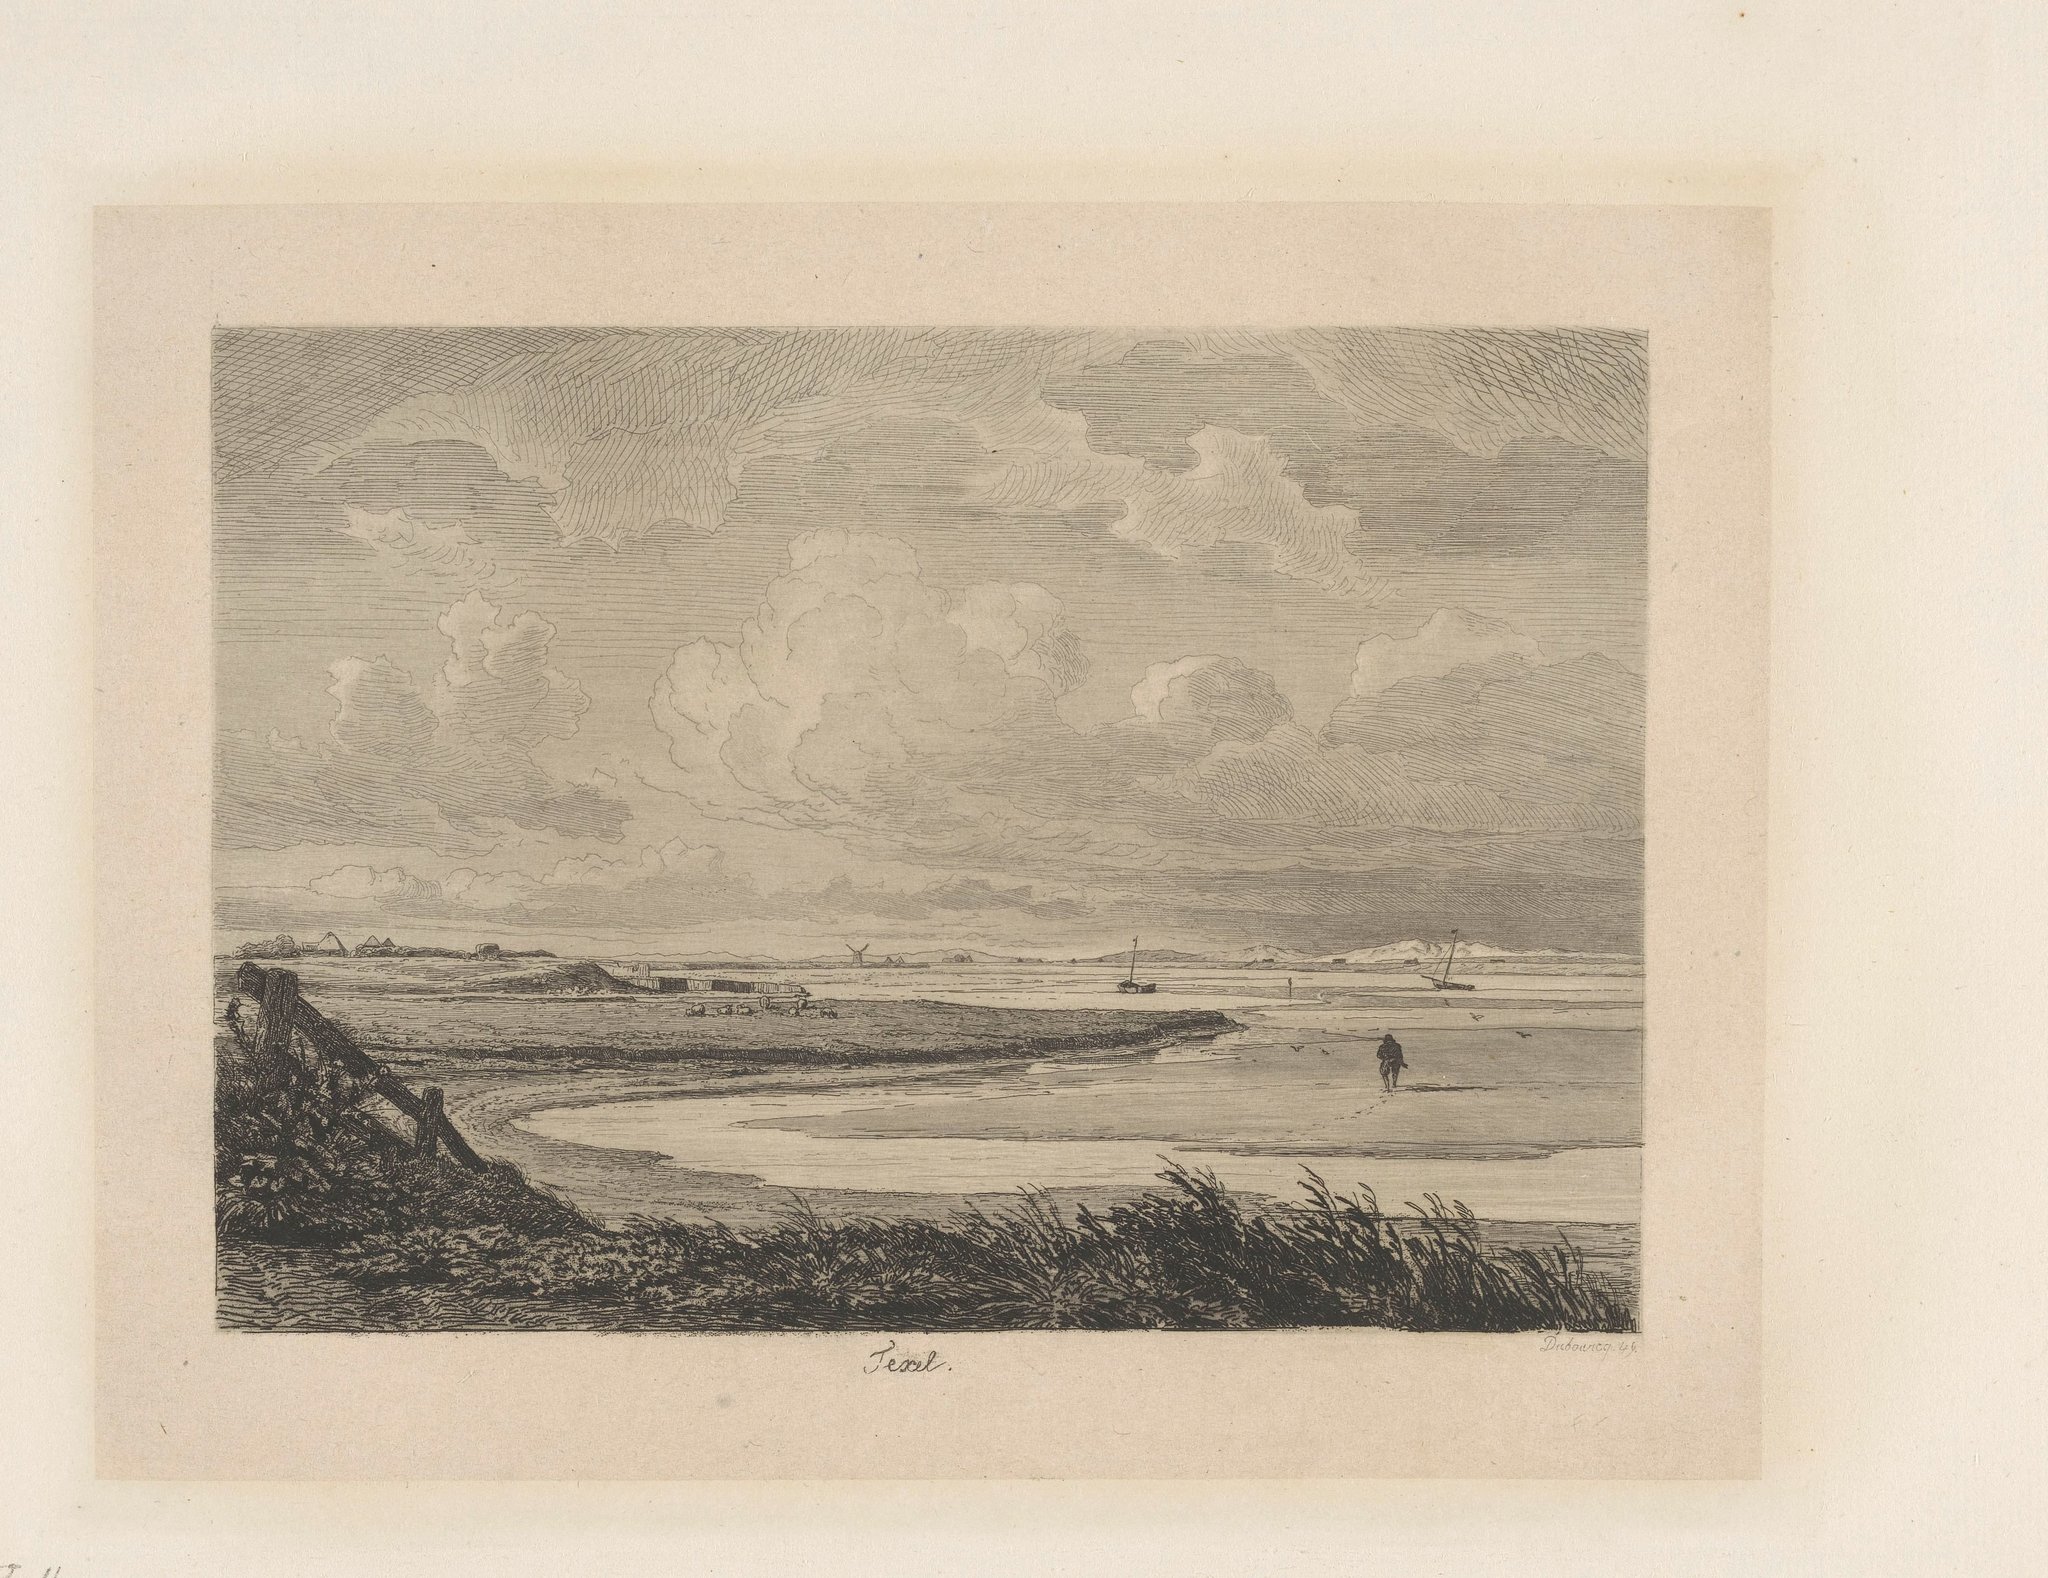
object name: print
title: Zes etsproeven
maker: pierre louis dubourcq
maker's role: draughtsman, painter, print maker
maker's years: 1815-1873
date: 1849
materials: paper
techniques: drypoint, etching, intaglio, roulette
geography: netherlands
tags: gulf, bay, mud flat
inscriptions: collector's mark: Lugt 2228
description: Gezicht op een baai aan de kust van Texel met een wadloper. Aan de overkant van de baai een kudde schapen. Twee boten zijn gedurende de eb droog gevallen.